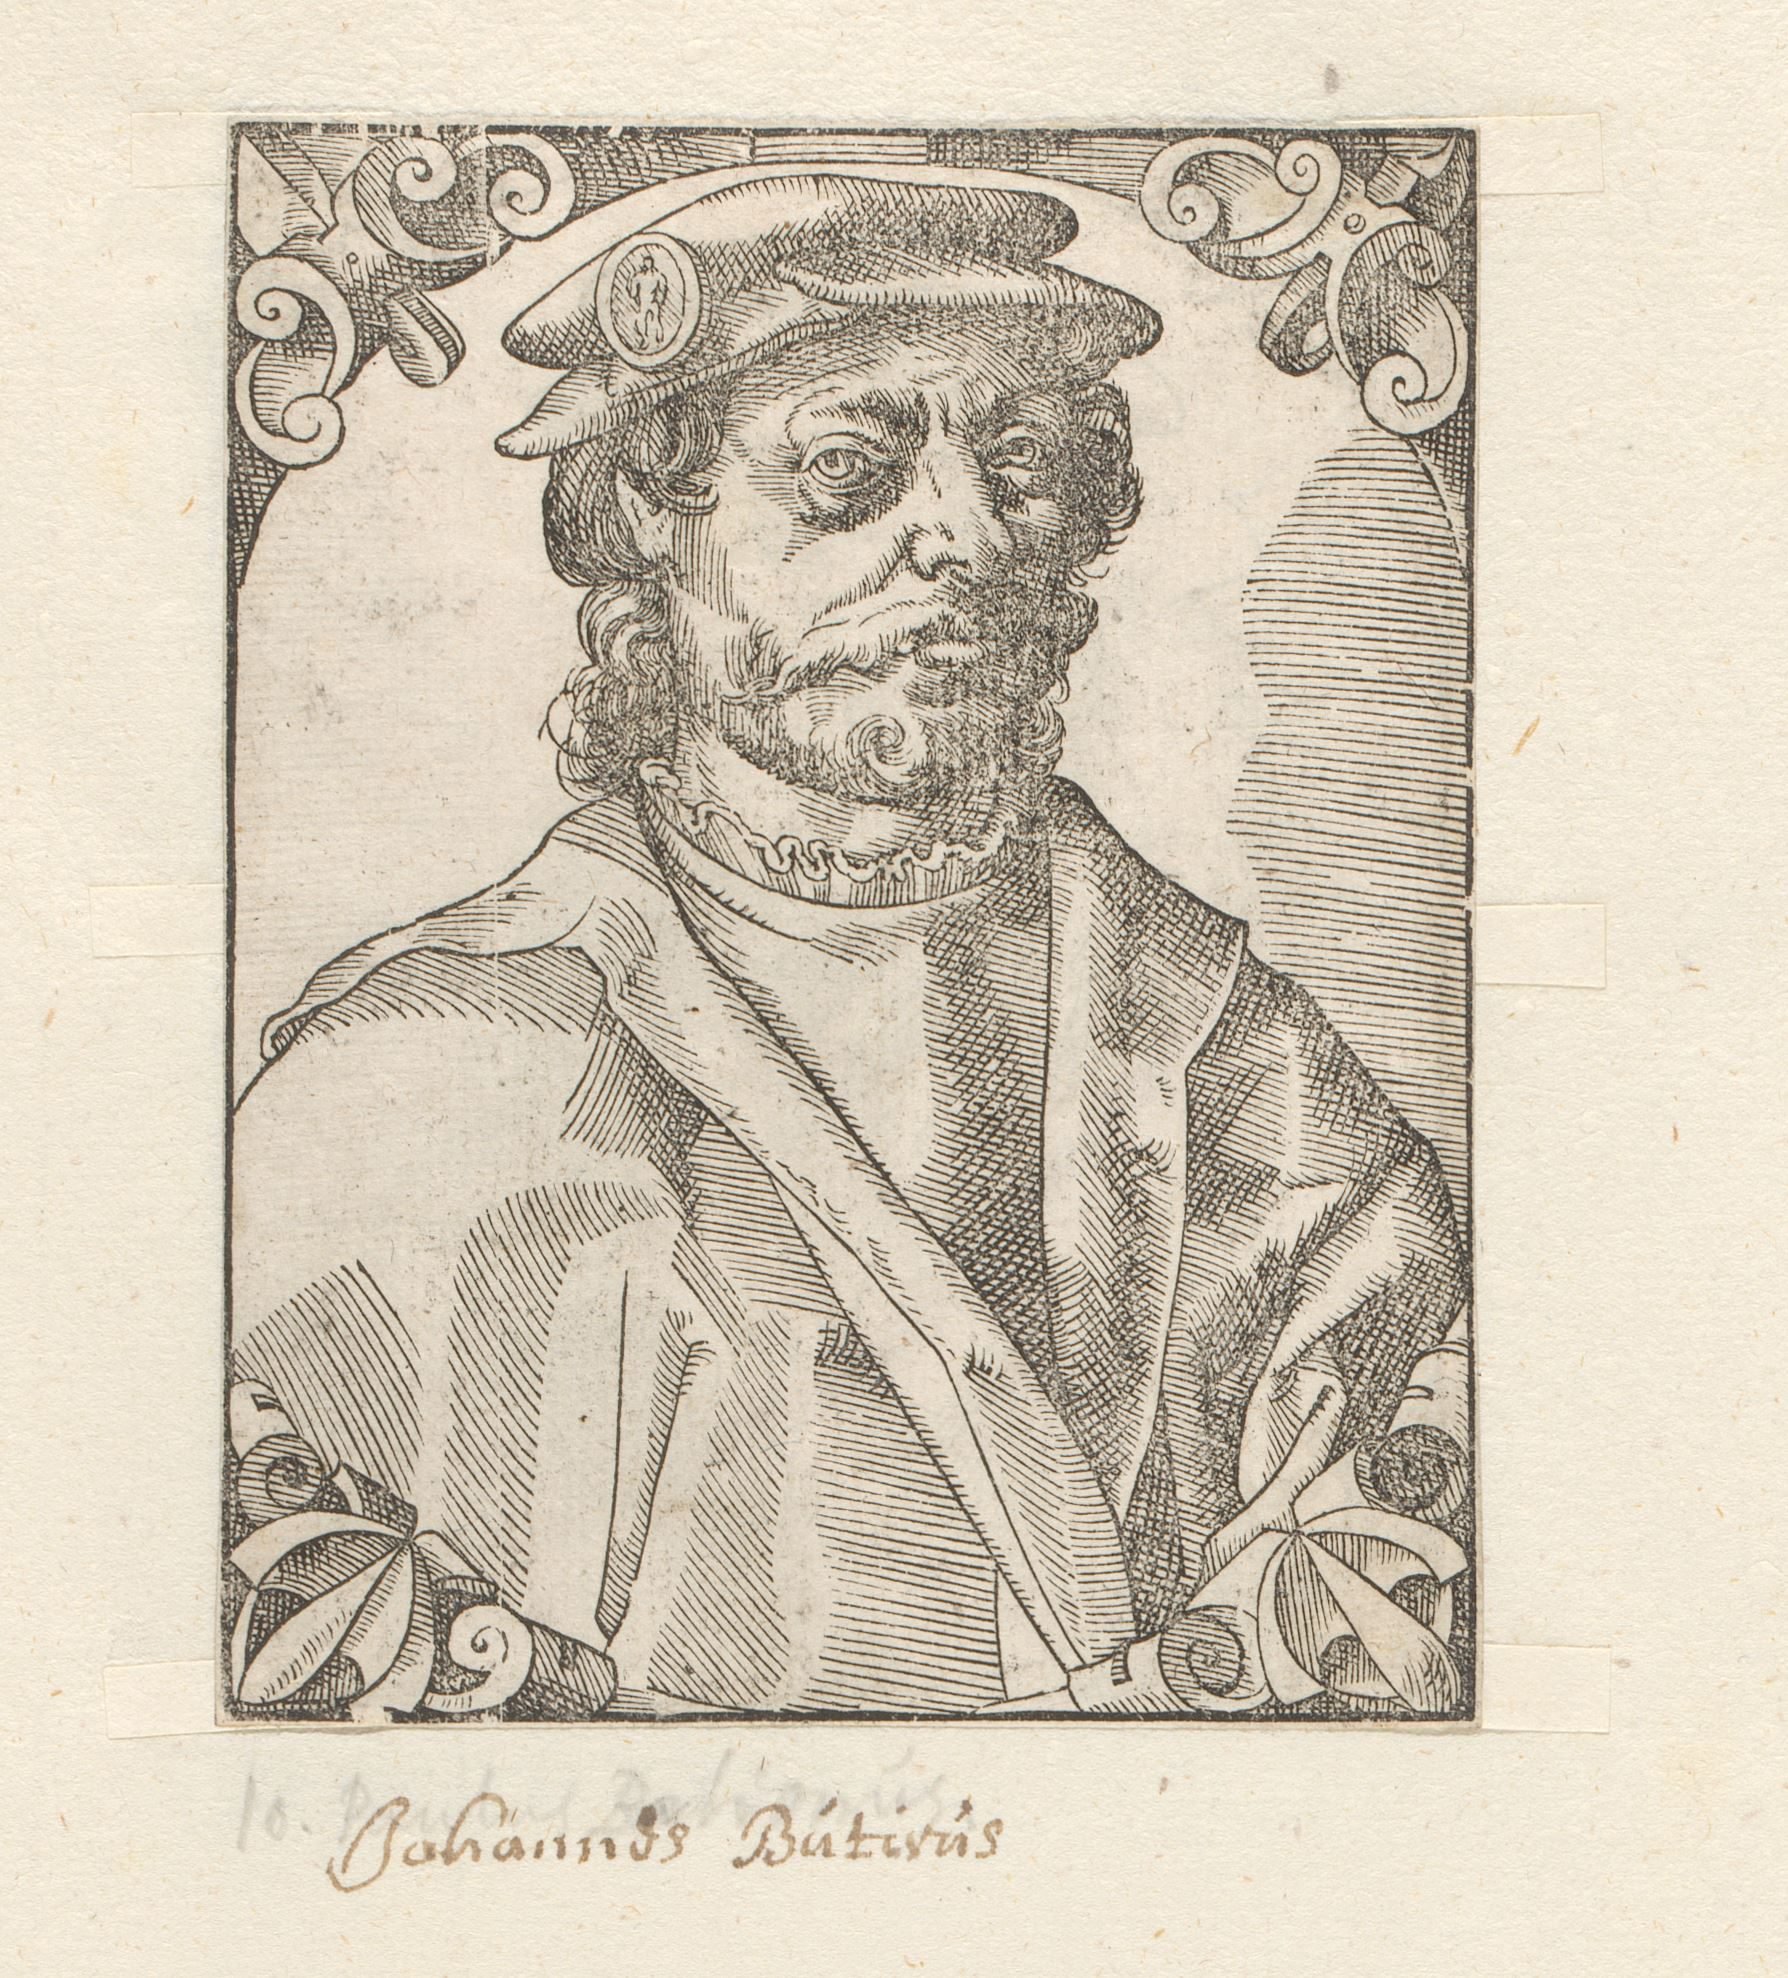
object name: album leaf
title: Portret van Gian Paolo Baglioni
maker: Anonymous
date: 1549-1575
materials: paper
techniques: woodcut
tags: rome, commander-in-chief, general, marshal, historical persons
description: Prent gebruikt in: Giovio, Paolo. Elogia Virorum bellica virtute illustrium (...). Bazel: Peter Perna, 1575.